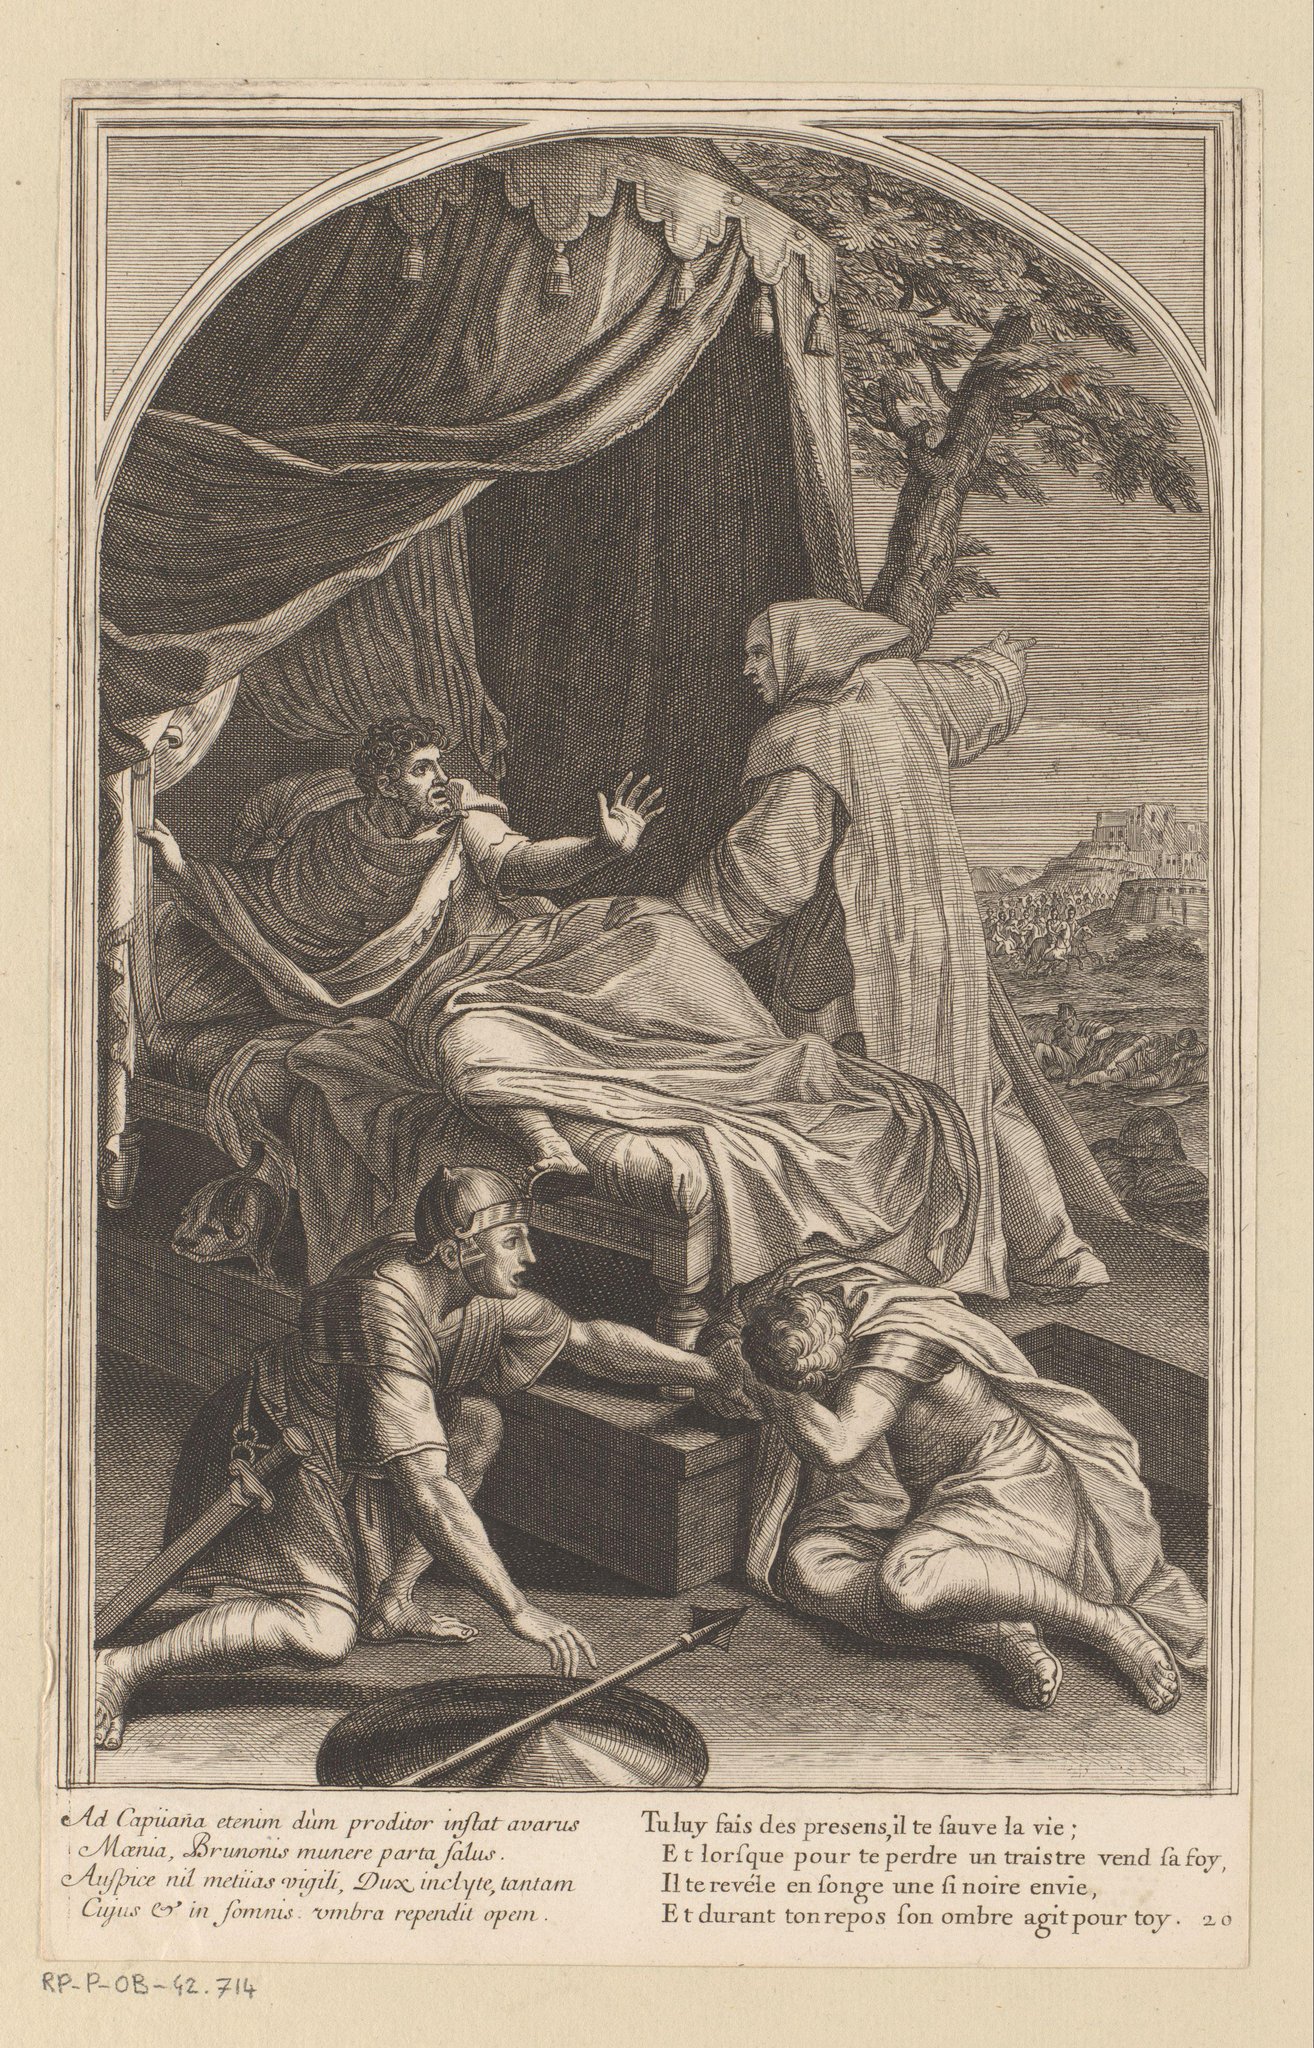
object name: print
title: La vie de St. Bruno (...)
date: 1623-1676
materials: paper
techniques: engraving, etching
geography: france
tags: the founder of the order of the carthusians, bruno; possible attributes: cross, finger at lips, lily, mitre at his feet, olive-branch, ray of light, skull, (seven) star(s)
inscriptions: collector's mark: Lugt 2165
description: Maakt deel uit van een serie met 24 prenten (inclusief twee titelprenten), naar schilderijen door Lesueur vervaardigd tussen 1645-1648 voor de Chartreuse de Paris. De serie is getiteld: La vie de St. Bruno fondateur de l'Ordre des Chartreux peinte au cloistre de la Chartreuse de Paris par Eustache Le Sueur.